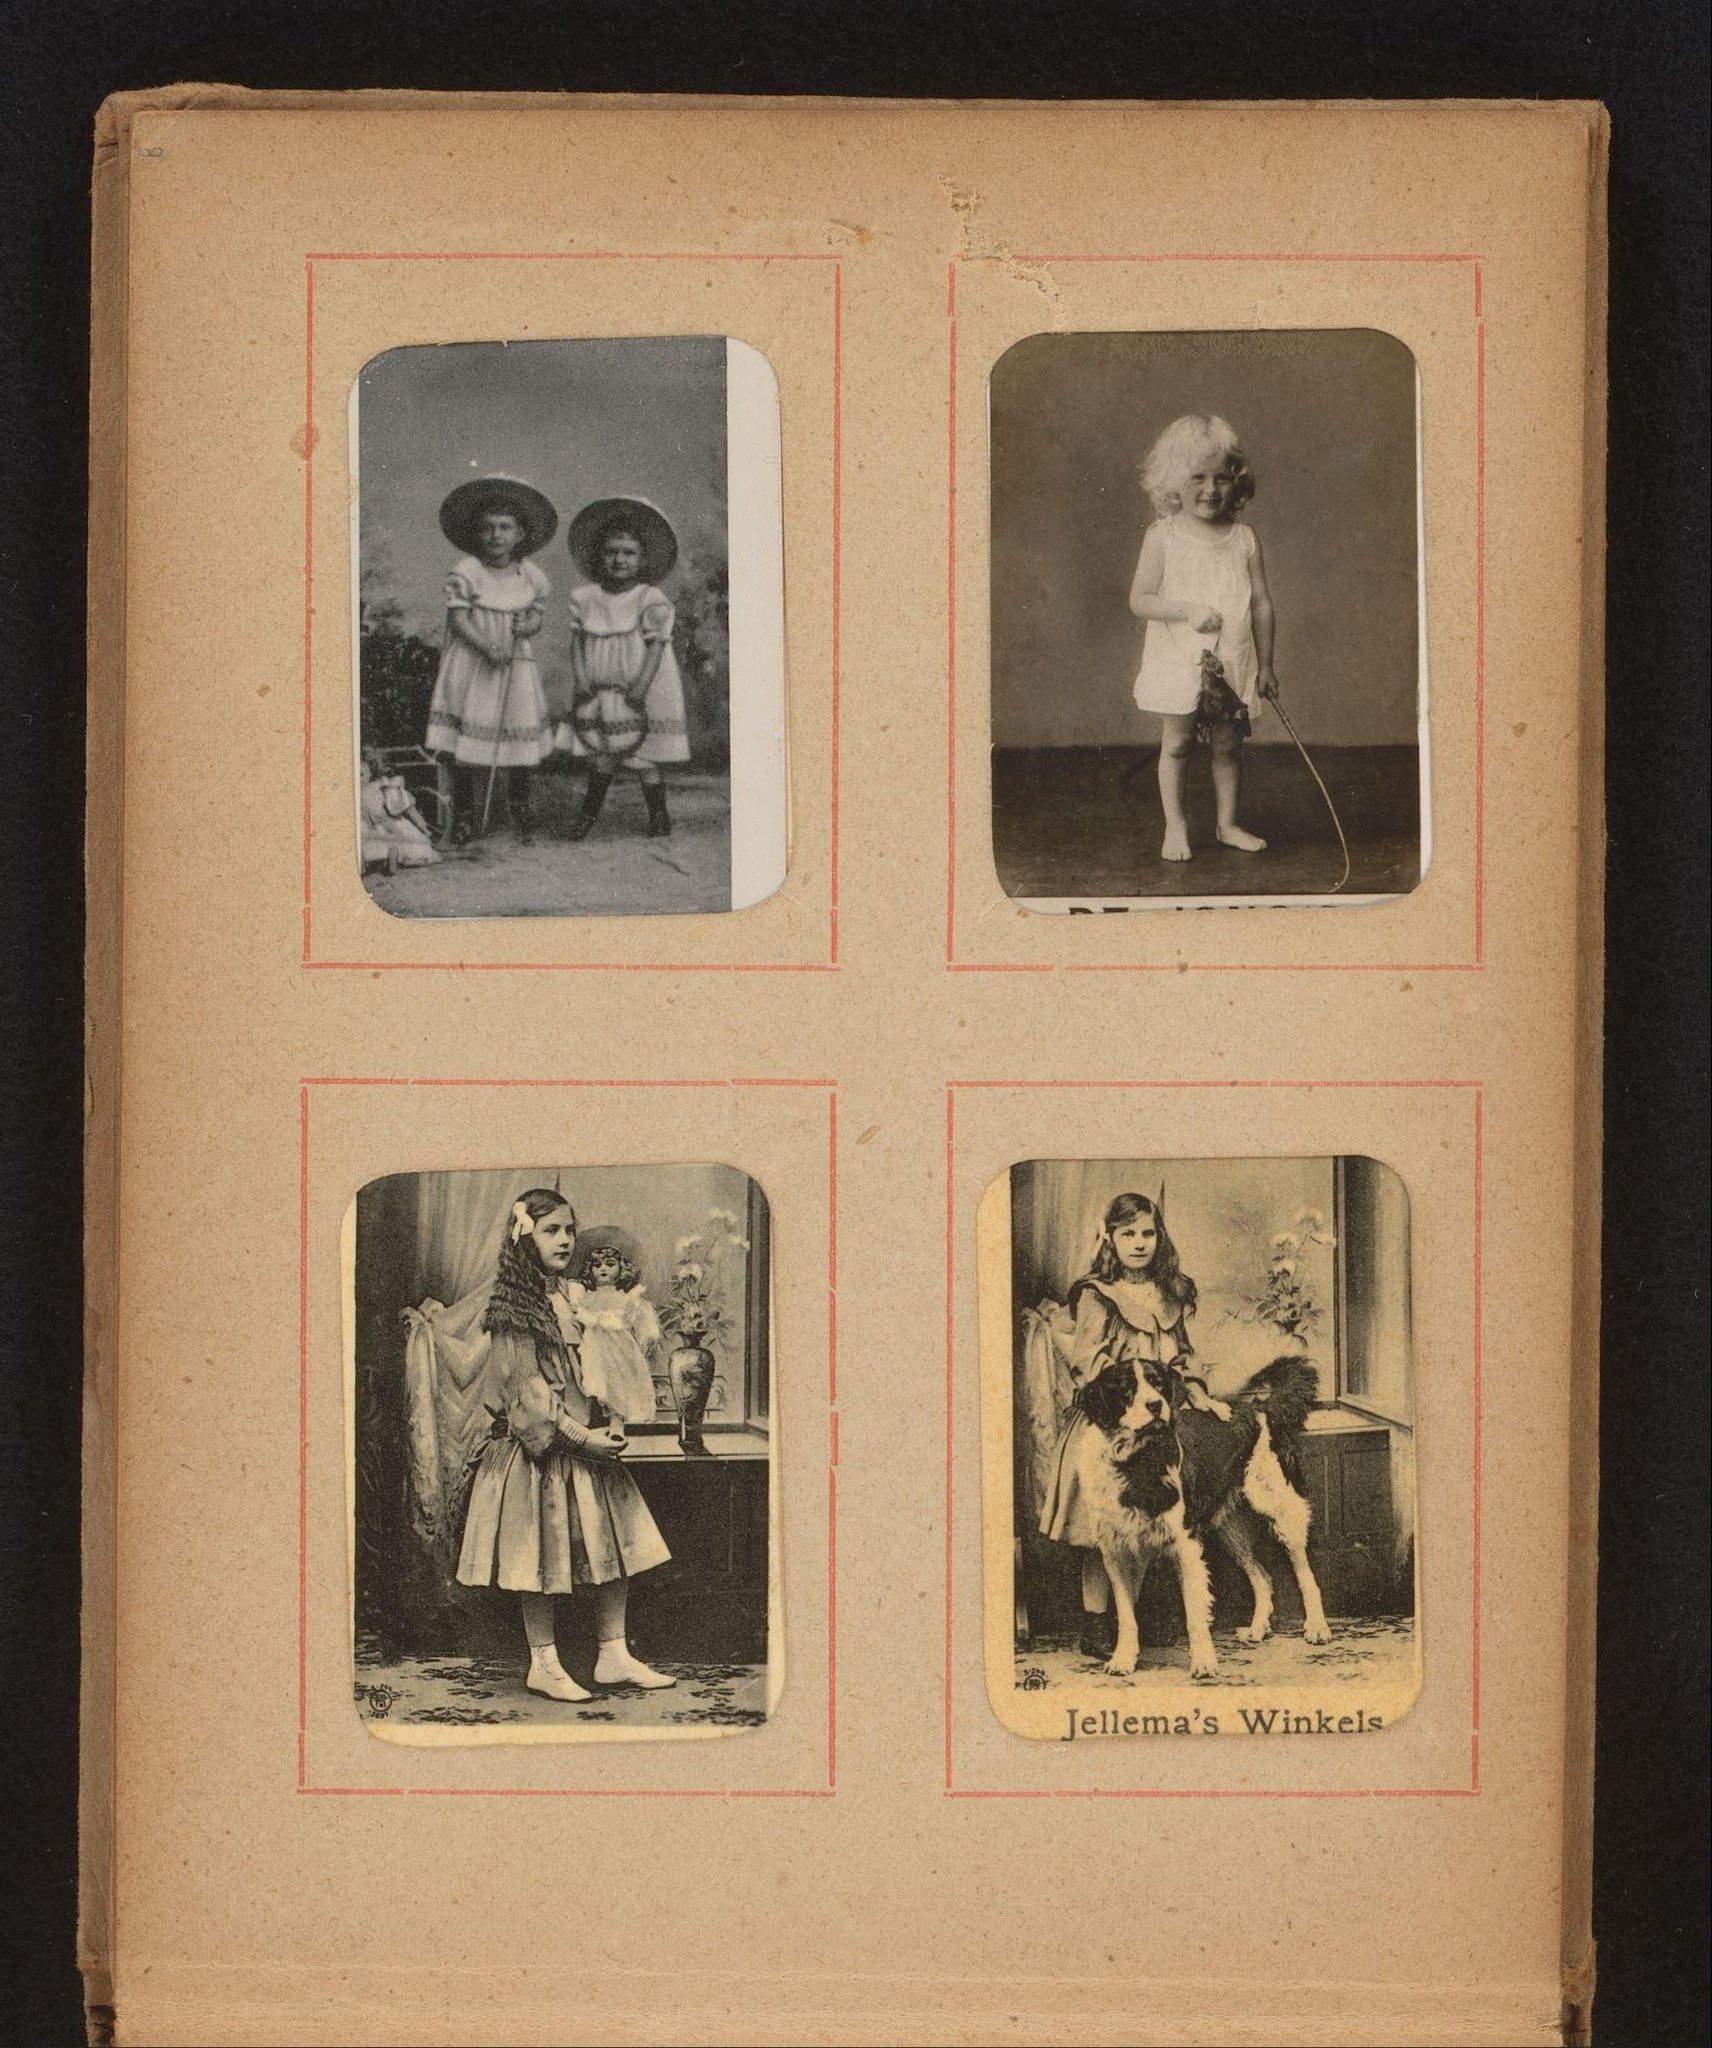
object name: photomechanical print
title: Kinderportretten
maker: Anonymous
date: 1880-1920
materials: paper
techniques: photograph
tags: child, (playing with) dolls, dog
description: Vier portretten van kinderen, waaronder een met het opschrift Jellema's Winkels. Deze pagina maakt deel uit van een album.